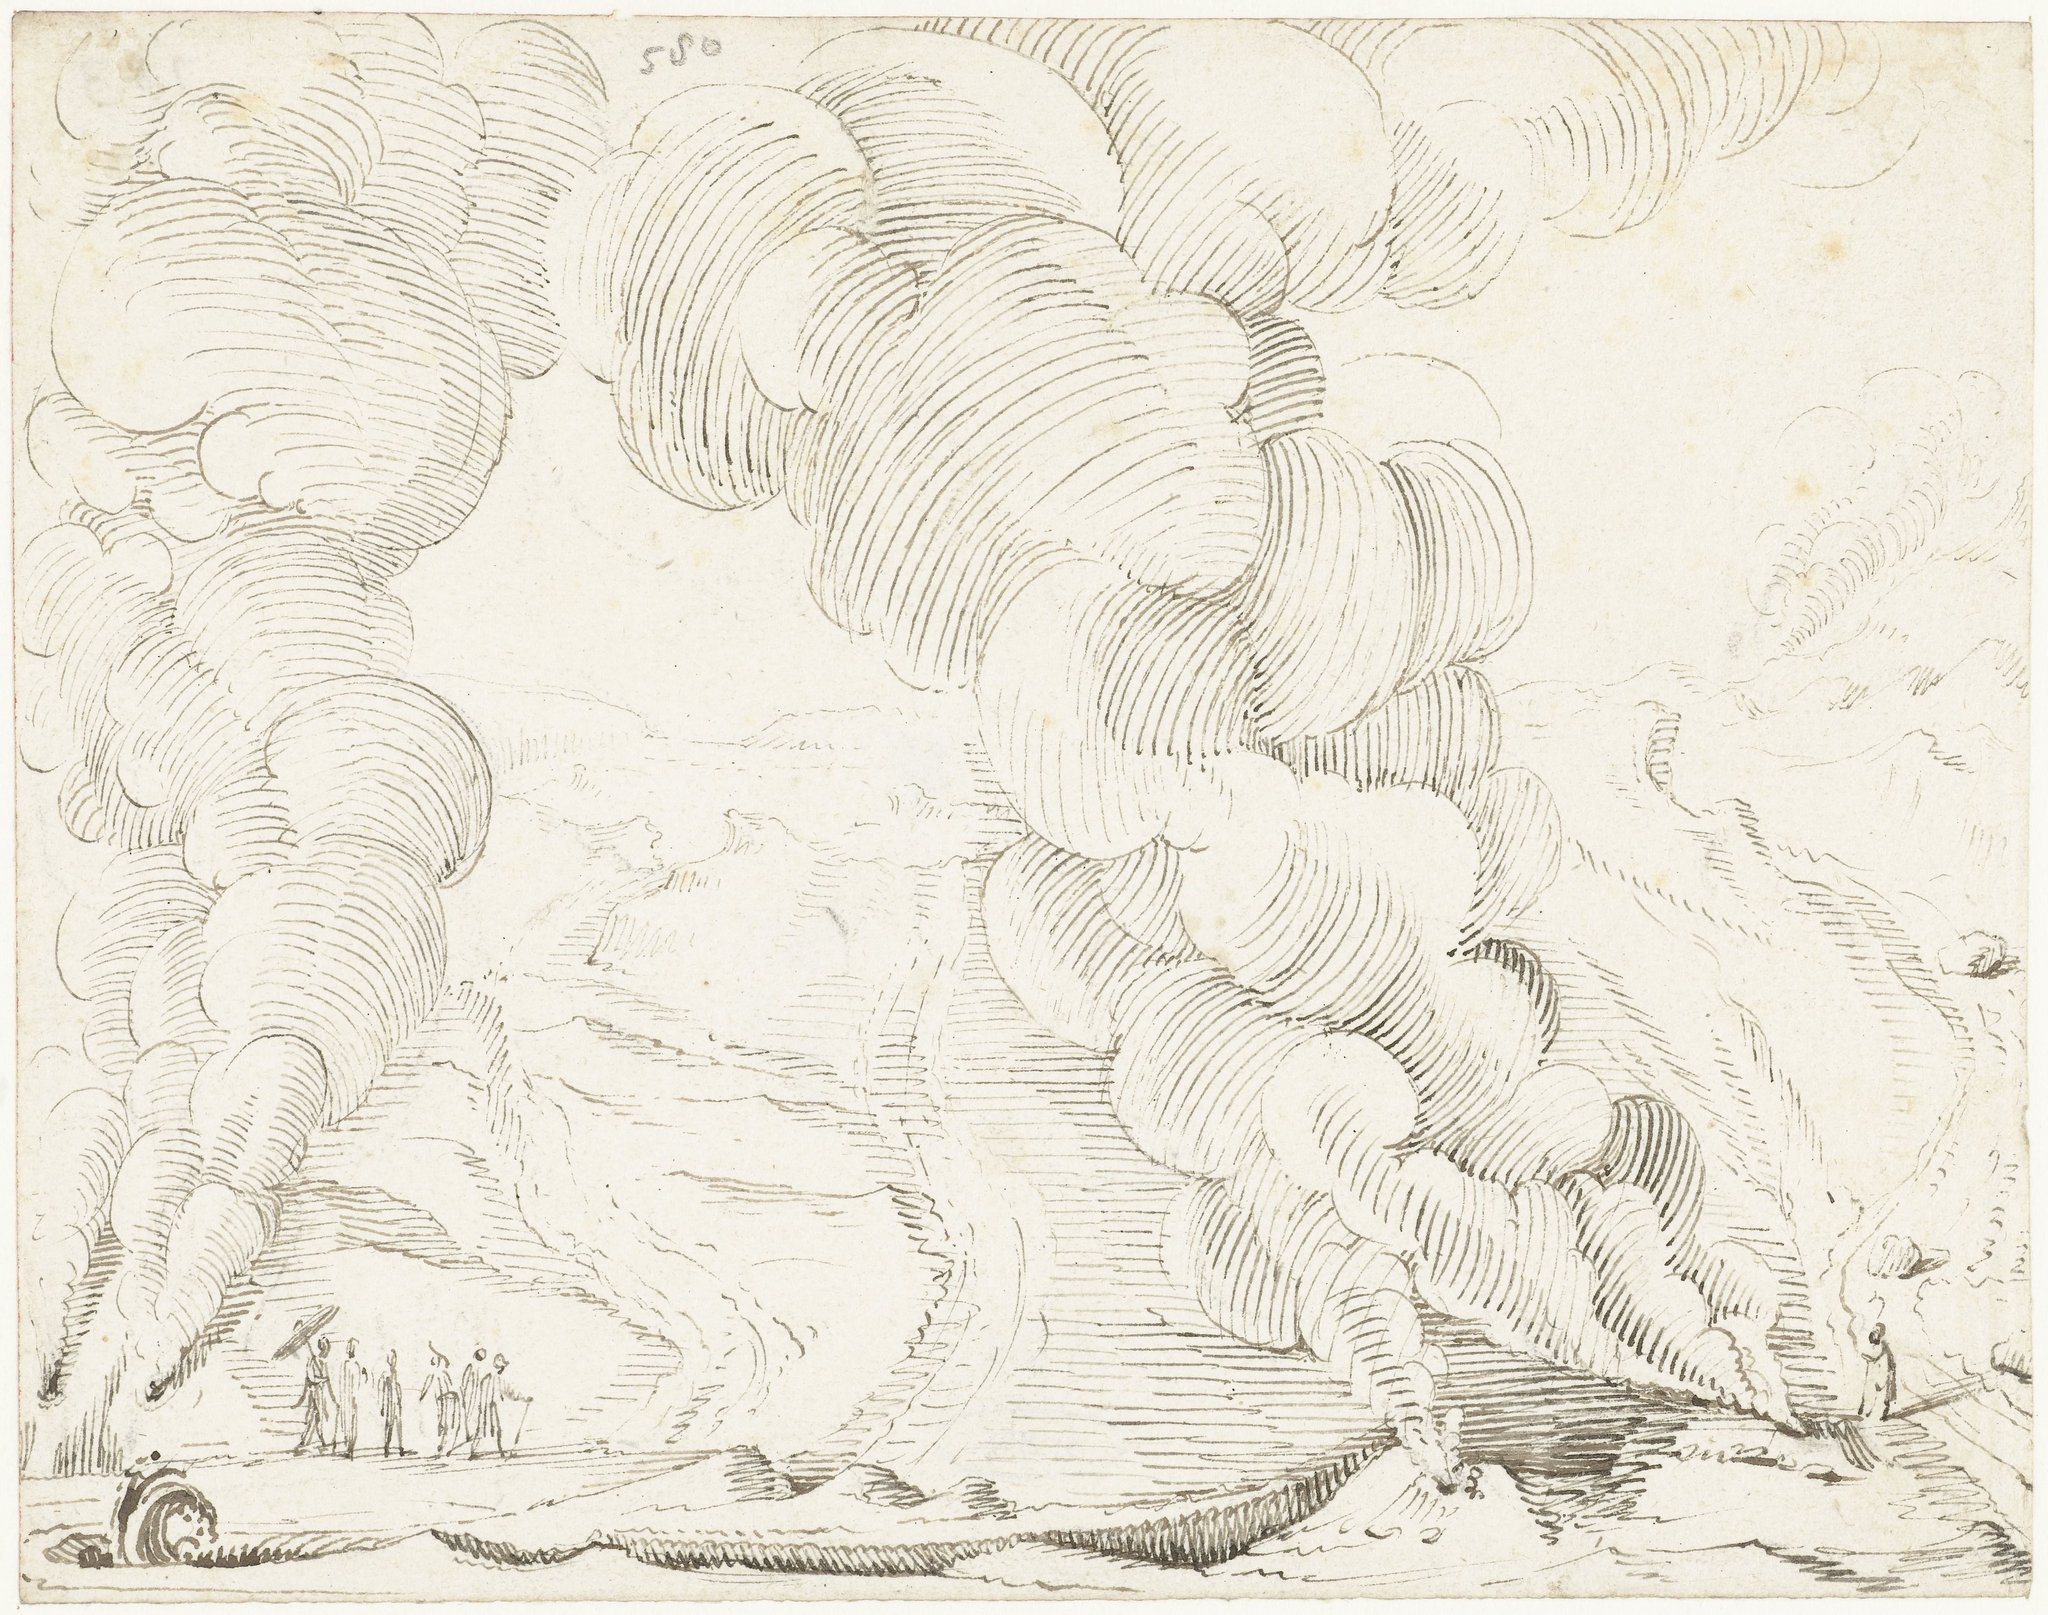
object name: drawing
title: Gezicht op de Solfatara bij Pozzuoli, buiten Napels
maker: gerard ter borch (i)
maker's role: draughtsman, print maker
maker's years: 1584-1662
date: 1611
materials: ink, paper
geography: pozzuoli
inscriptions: annotation: ‘183’